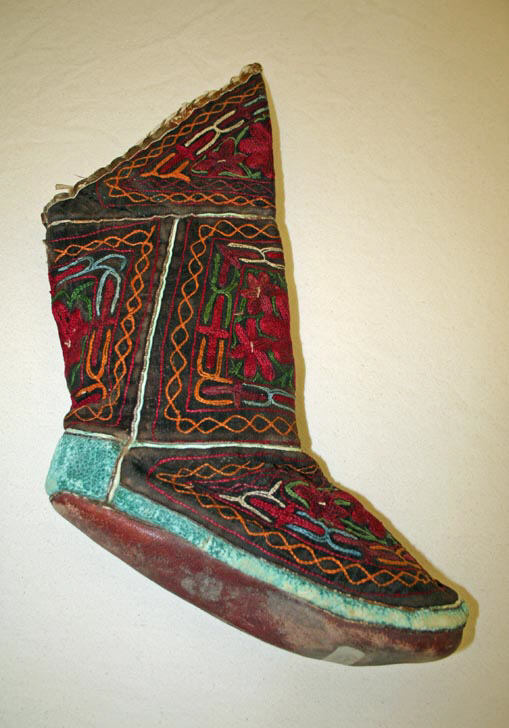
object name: boot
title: Boots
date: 1801-1900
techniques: embroidery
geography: russia